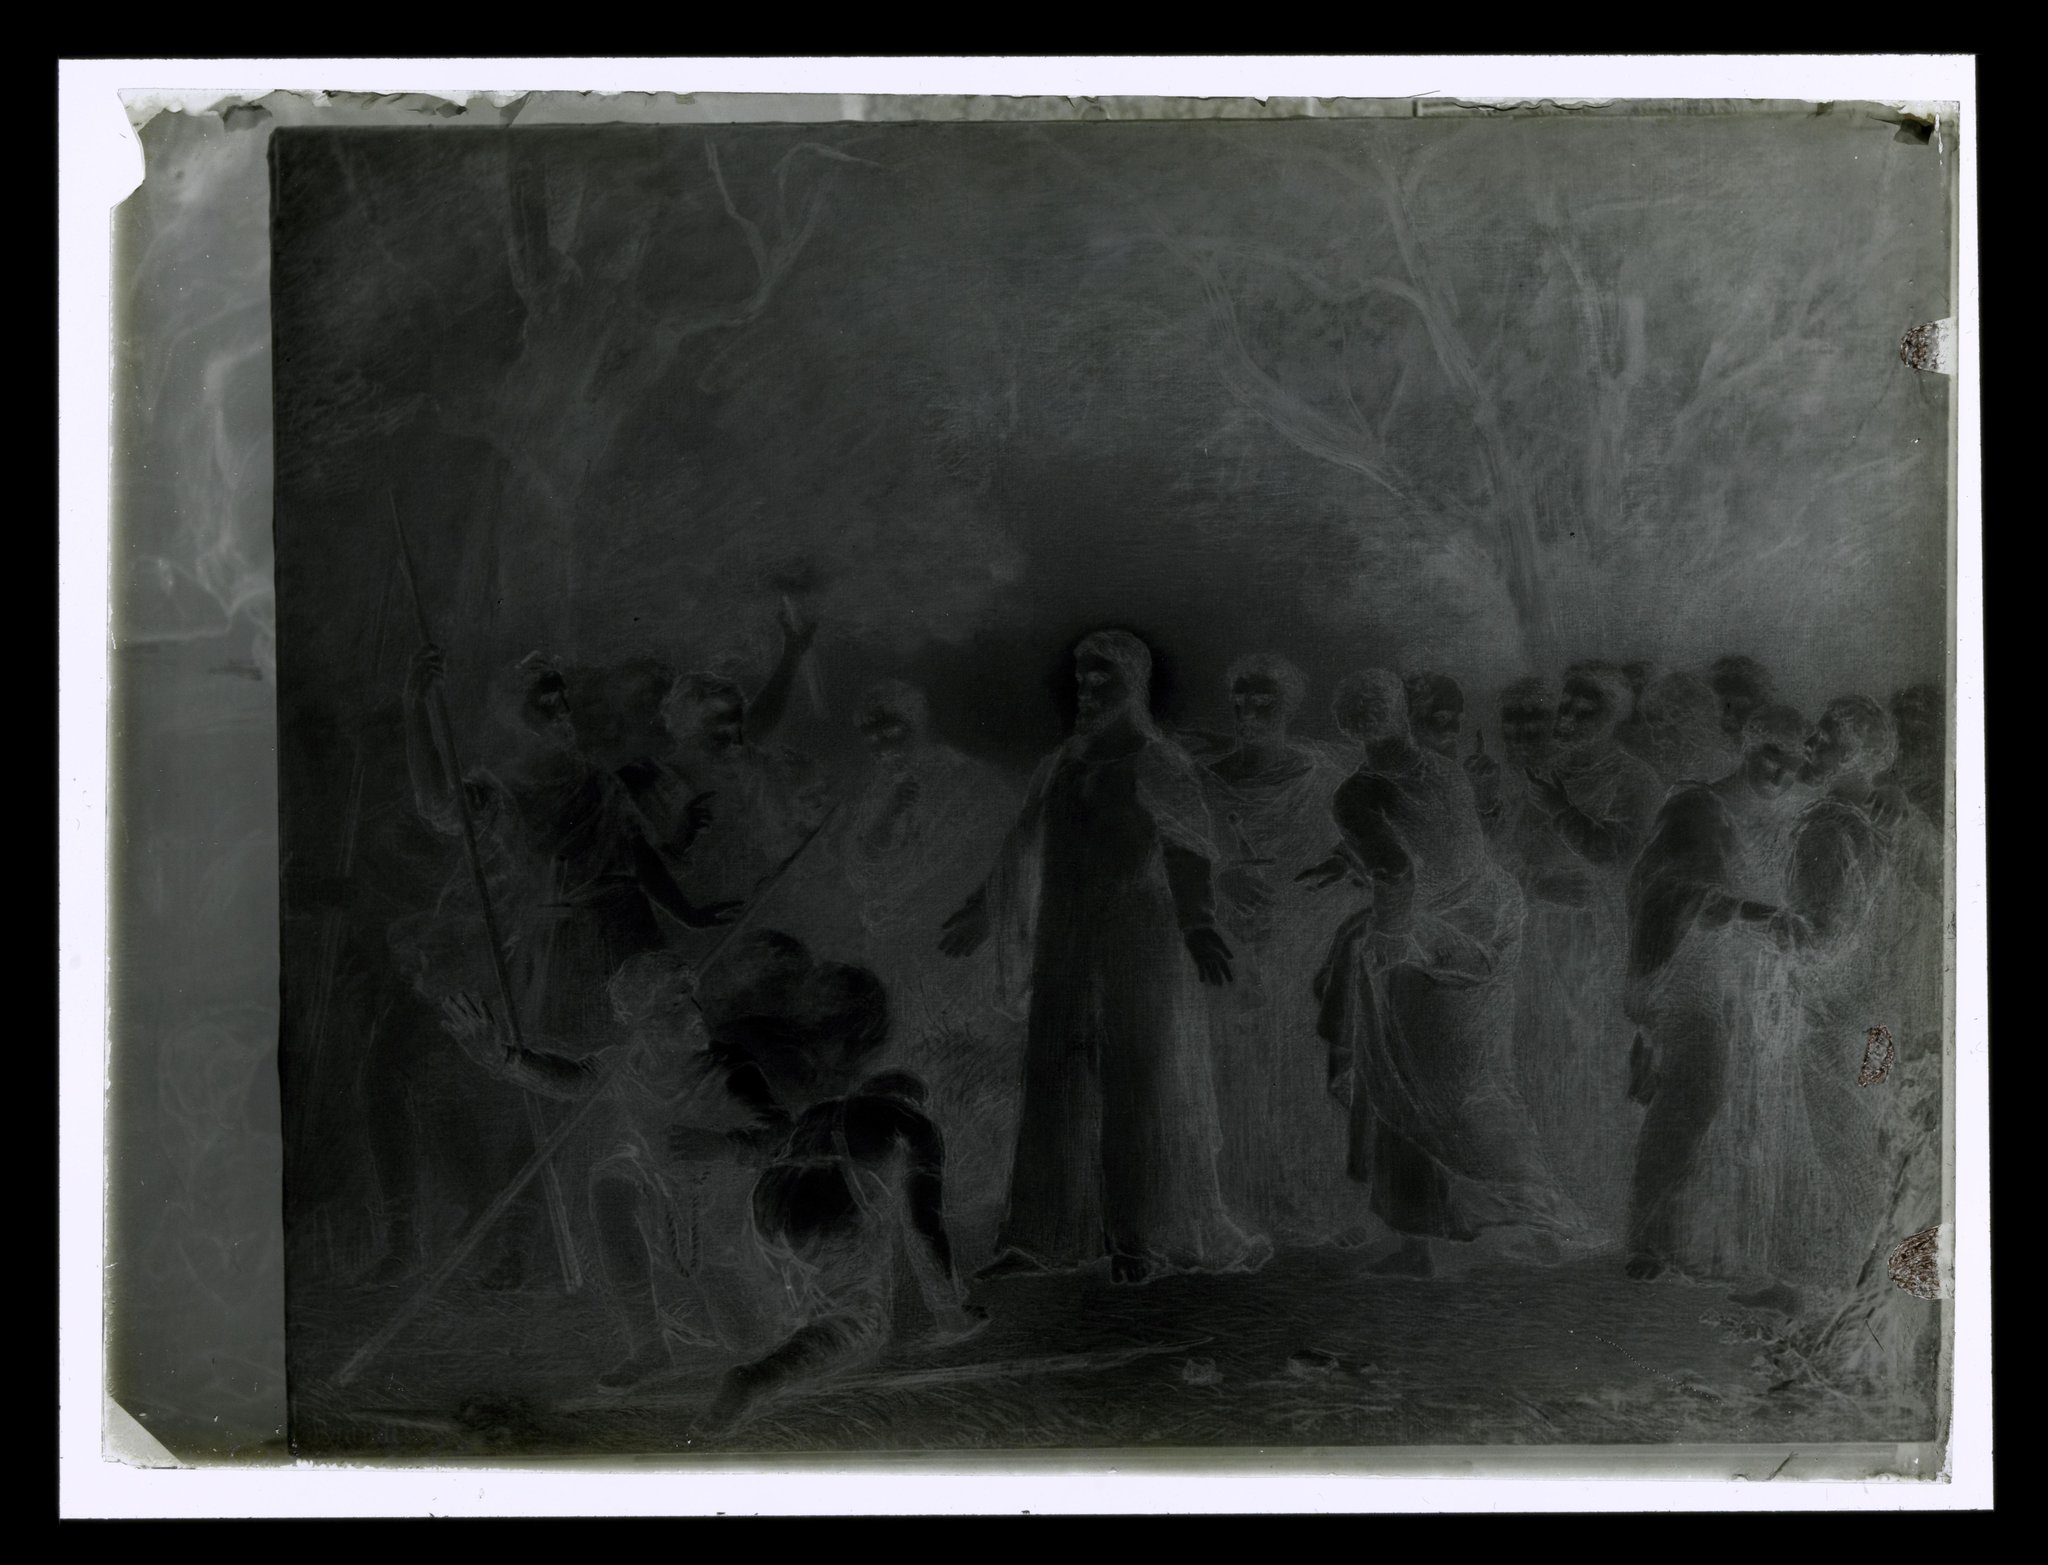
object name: glasnegatief, glasplaatnegatief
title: Fotoreproductie van een schilderij van Christus in een bos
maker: laurens lodewijk kleijn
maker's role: draughtsman, painter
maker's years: 1826-1909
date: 1865-1900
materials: glass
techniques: collodion process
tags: christ, picture, painting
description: Onderdeel van groep glasnegatieven uit de nalatenschap van de schilder Laurens Lodewijk Kleijn, stillevens, portretten, zelfportretten en kunstreproducties.